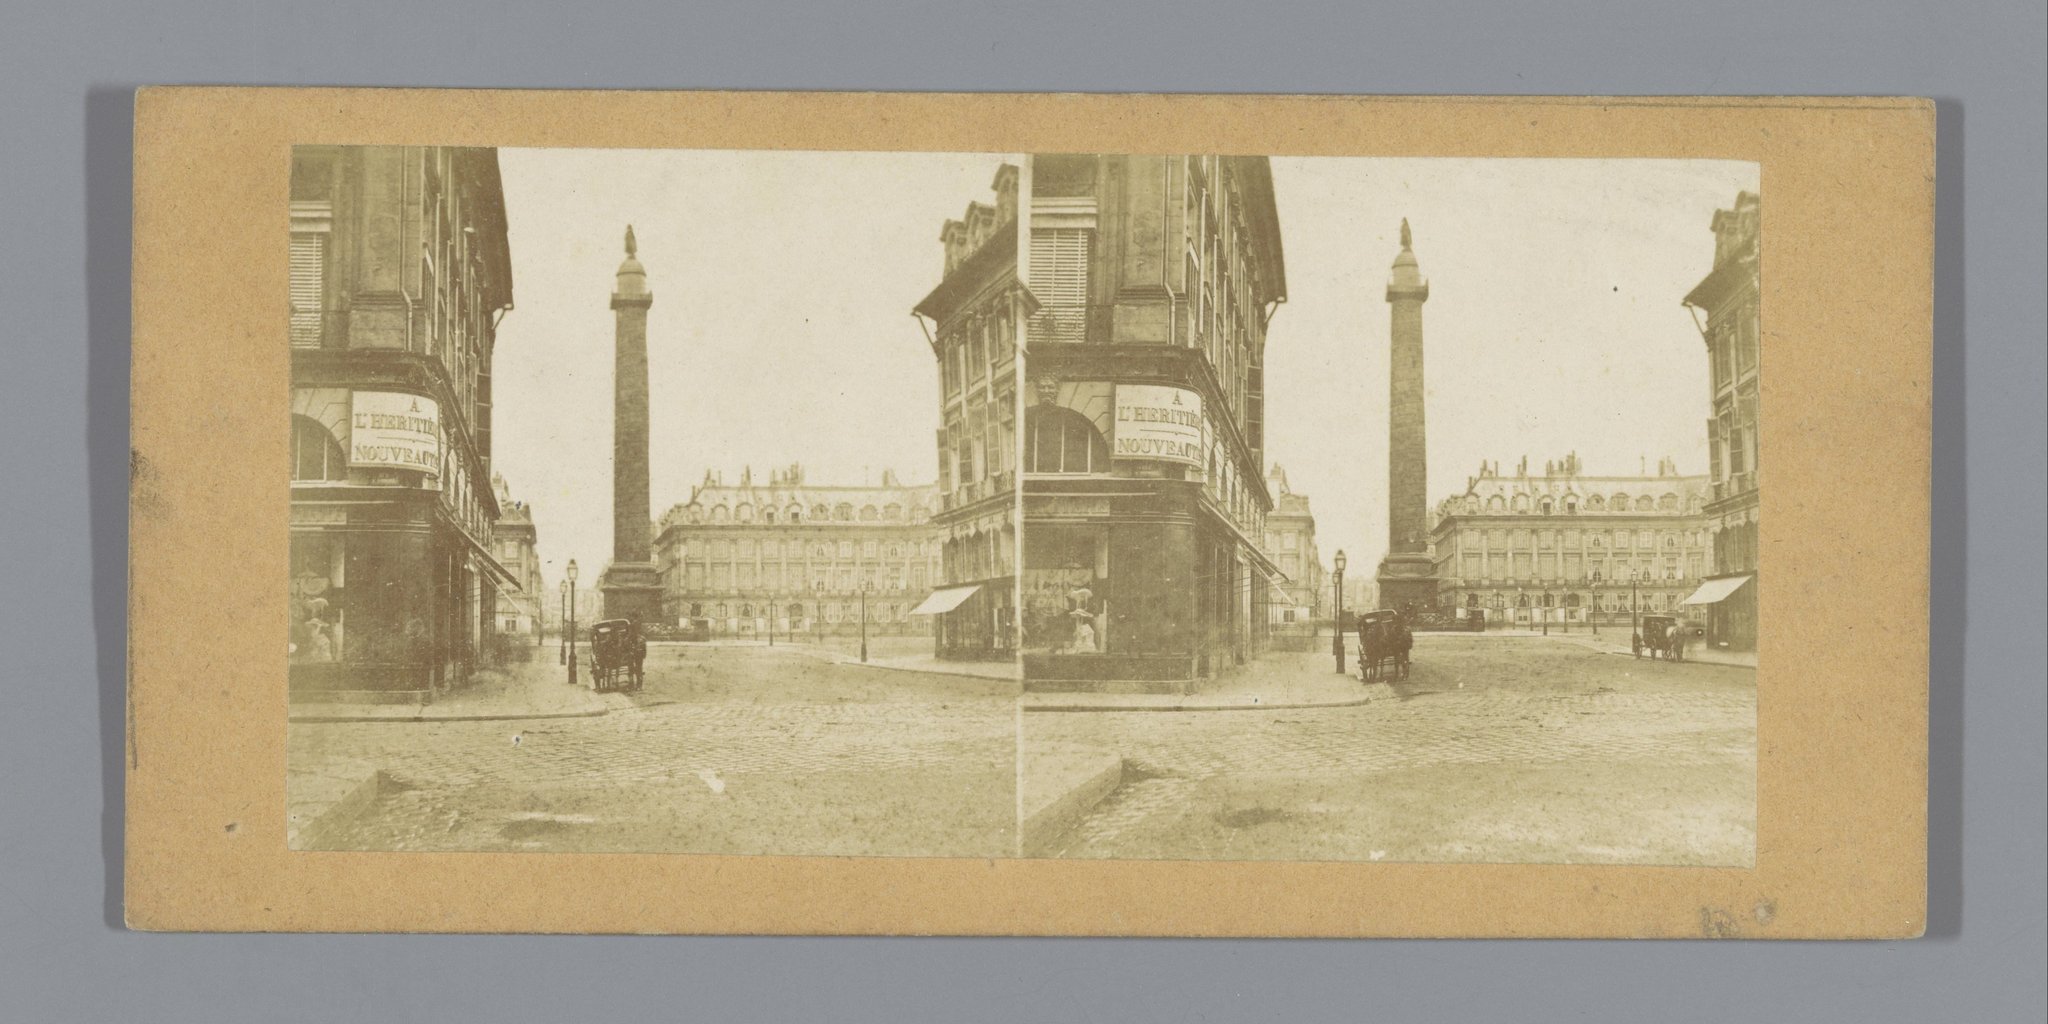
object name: stereograph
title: Gezicht op de Colonne Vendôme te Parijs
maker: Anonymous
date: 1855-1880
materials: cardboard, photographic support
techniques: albumen print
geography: paris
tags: square, place, circus, etc., triumphal column with helical friezes